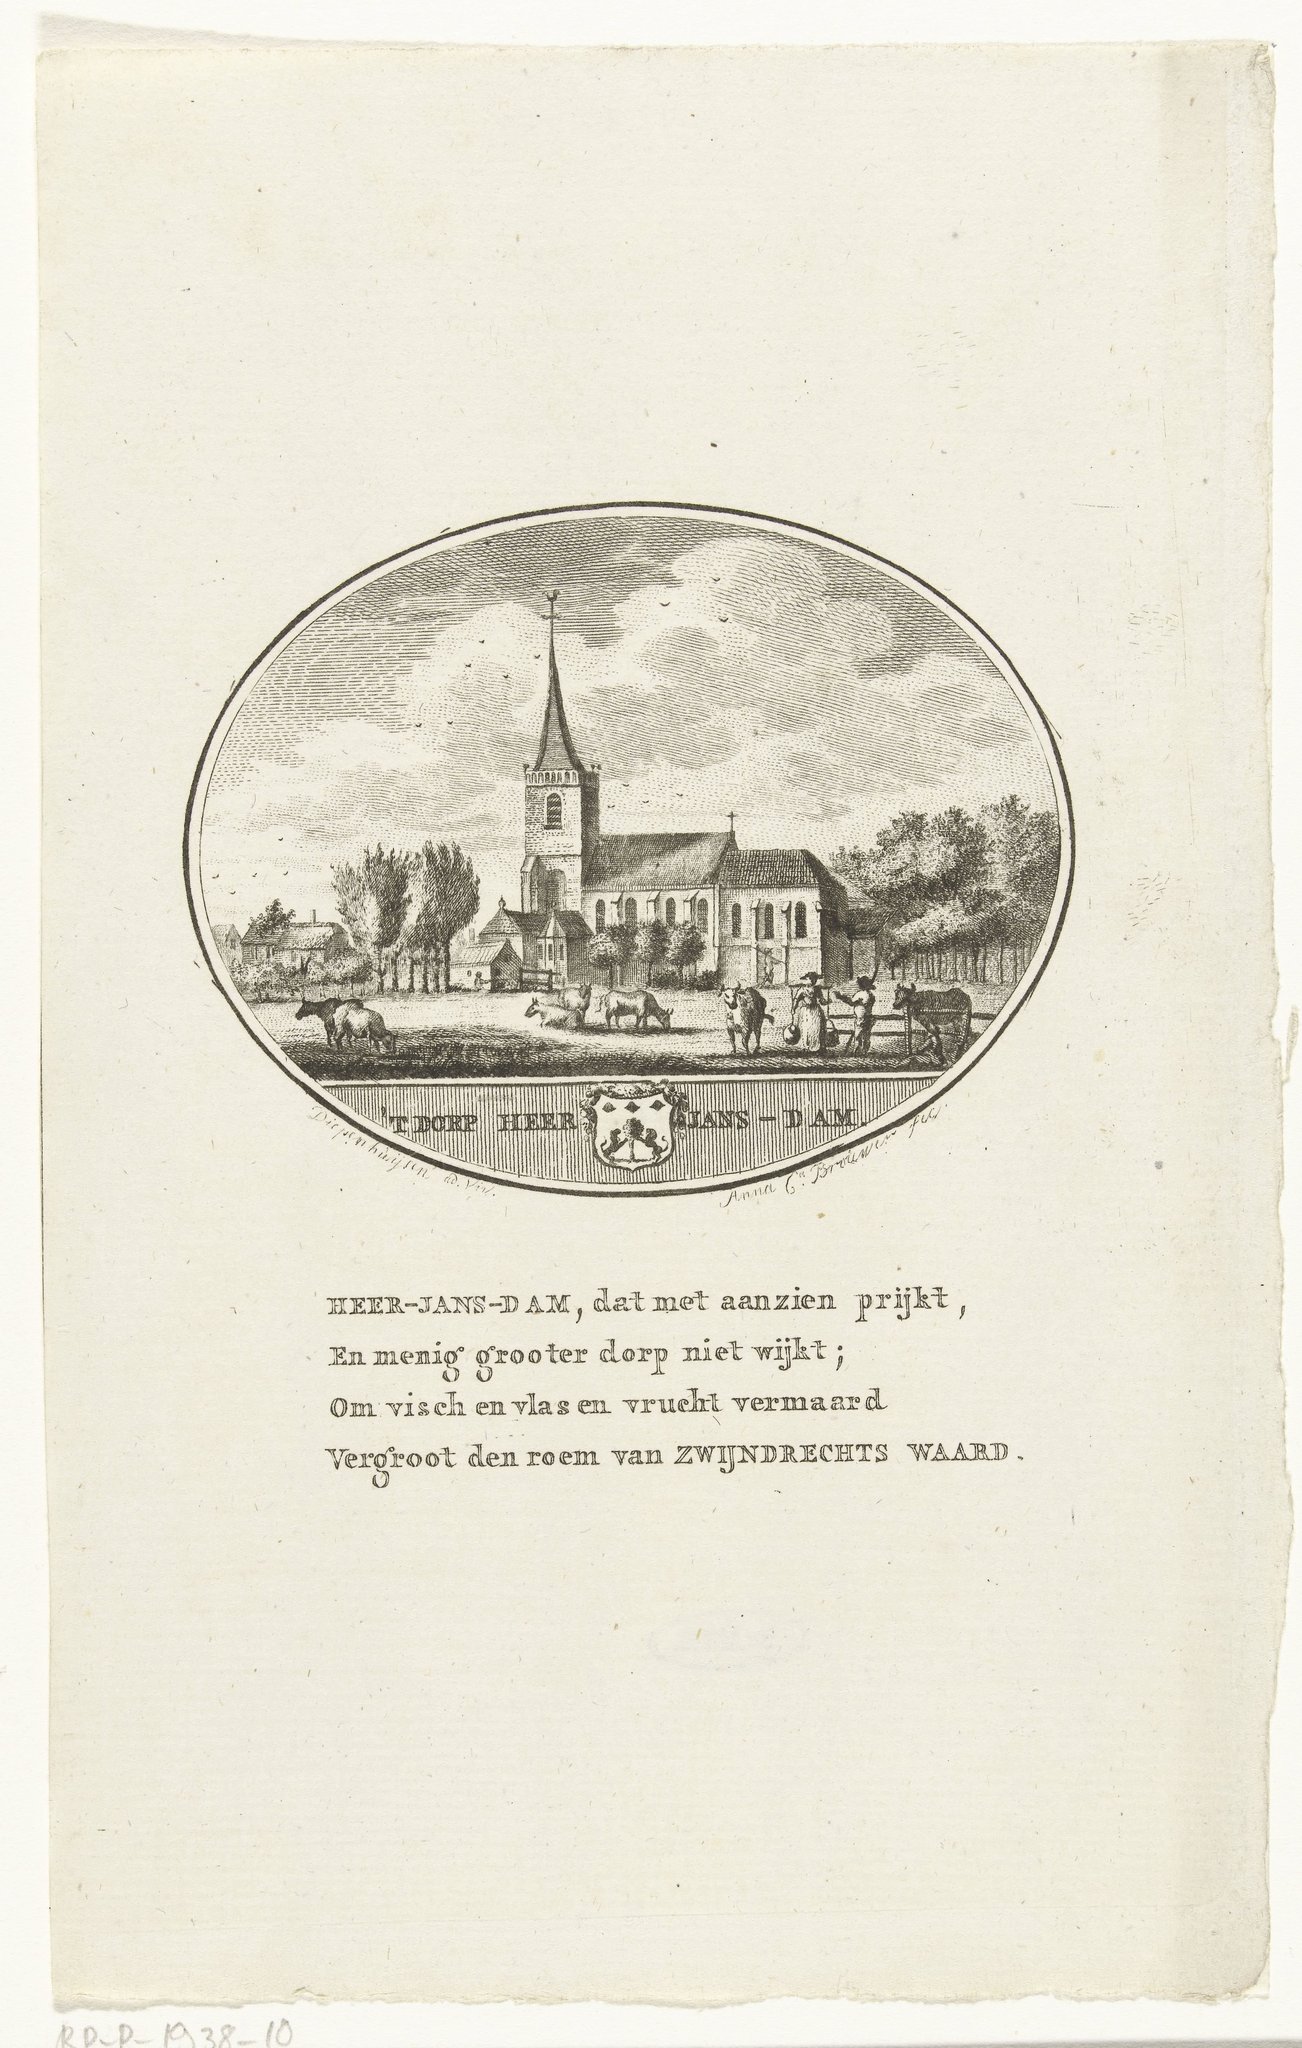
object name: print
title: Gezicht op de kerk van Heerjansdam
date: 1791-1793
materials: paper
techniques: etching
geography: amsterdam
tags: city-view in general; 'veduta'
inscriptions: collector's mark: Lugt 2228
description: afkomstig uit: L. van Ollefen, De Nederlandsche stad- en dorp-beschrijver. Deel 1, Amsterdam: Hendrik Arend Banse, 1793.